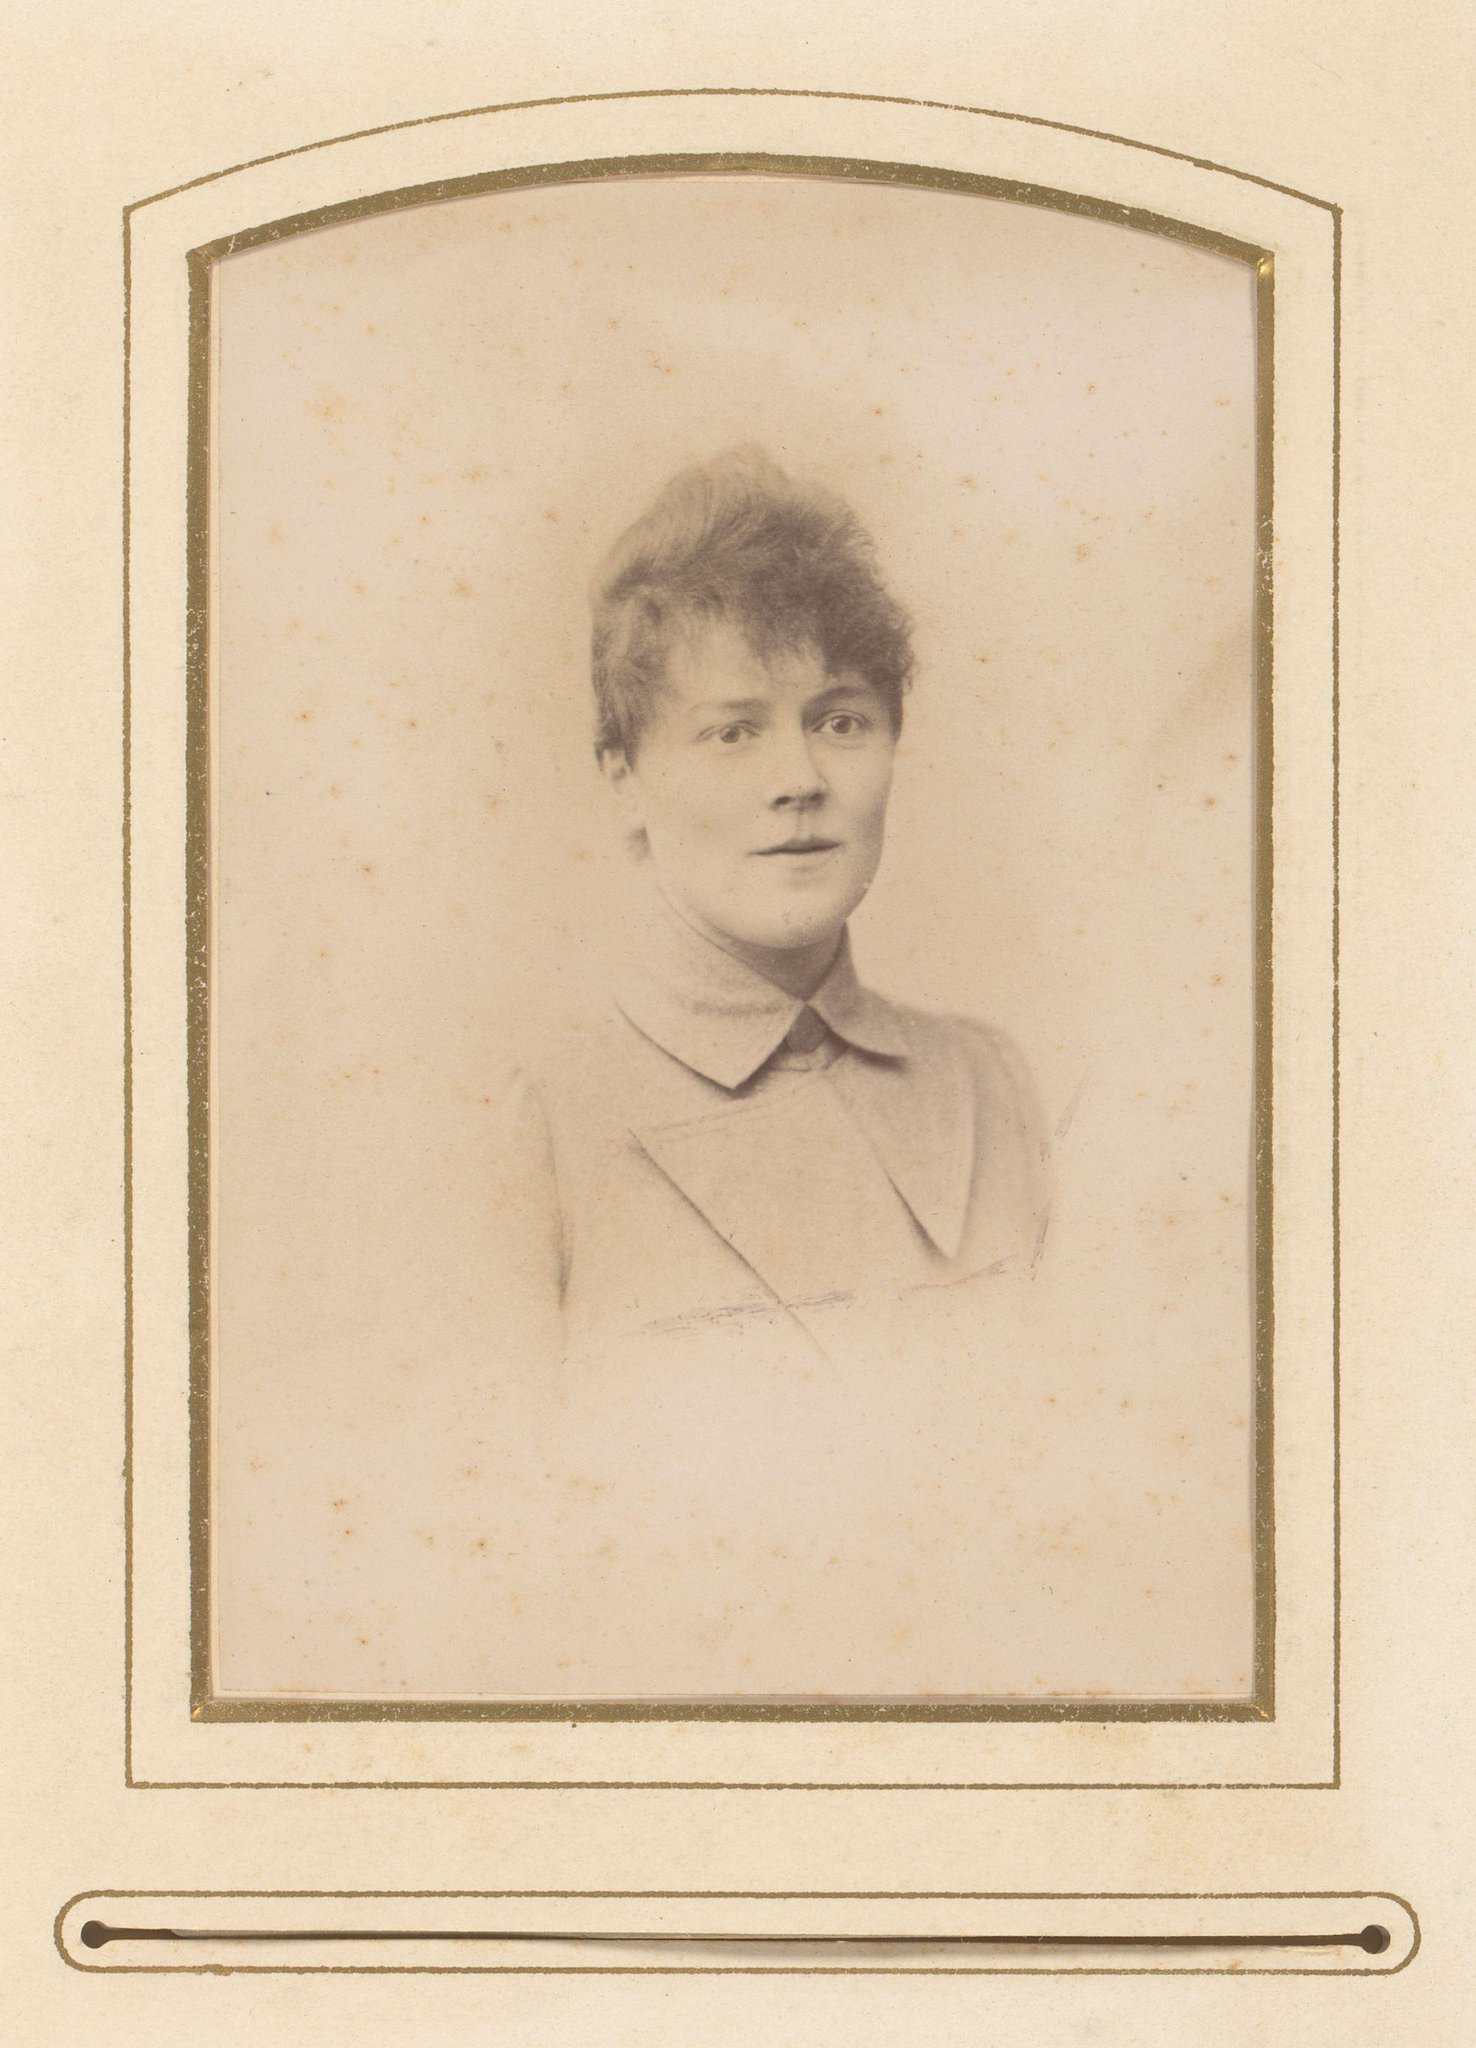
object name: photograph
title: Portret van een vrouw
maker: clément bannel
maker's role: fotograaf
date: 1850-1900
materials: cardboard, photographic support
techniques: albumen print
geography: paris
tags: historical persons - bb - woman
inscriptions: inscription: ‘Peintures, Photographies, Pastels/ Emaux - Reproductions/ A. Bannel/ 6, Boulevard des Italiens/ Paris/ (Ancienne Maison Disderi)’